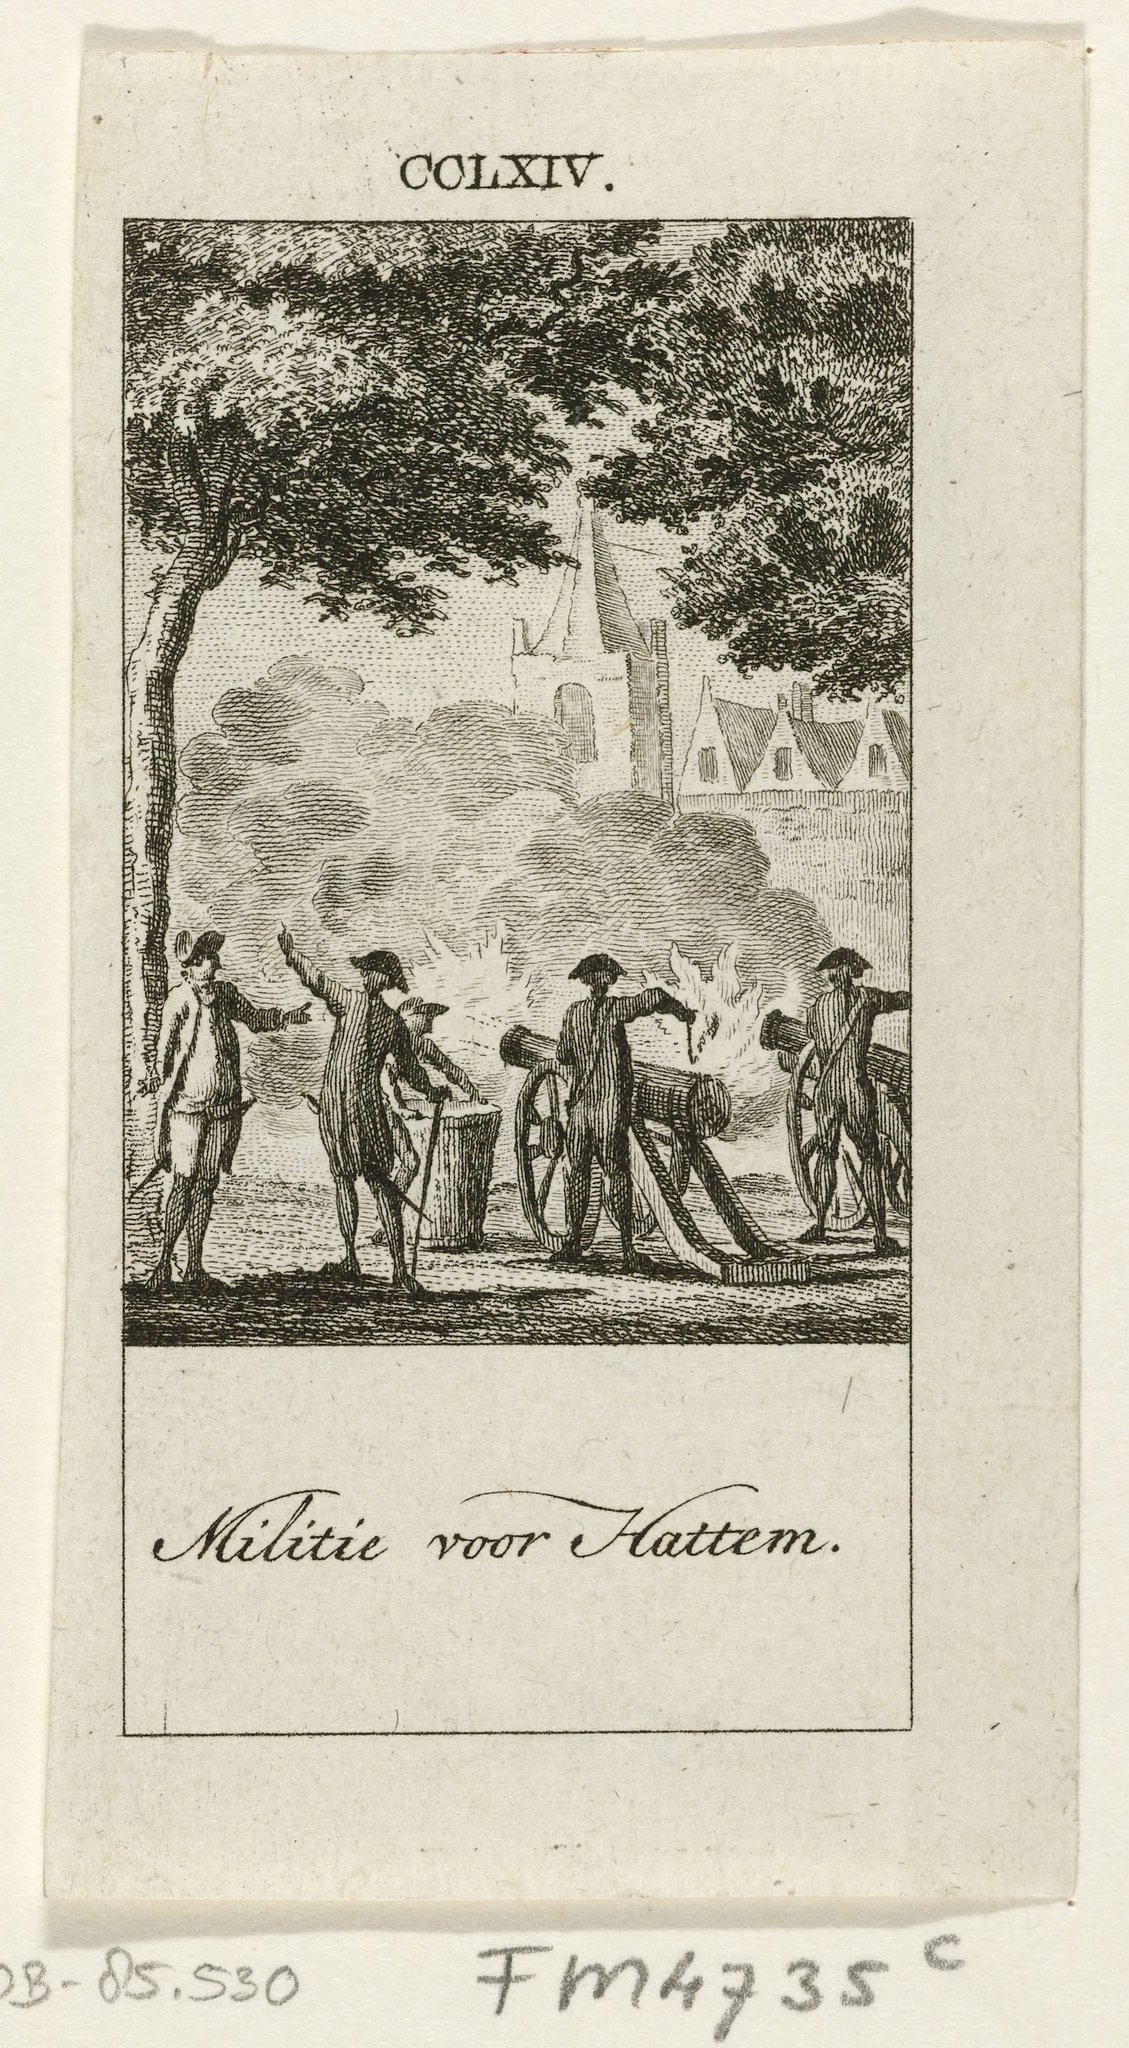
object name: print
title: Beschieting van Hattem, 1786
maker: Anonymous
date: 1786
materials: paper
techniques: engraving, etching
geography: northern netherlands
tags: bombardment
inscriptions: collector's mark: Lugt 2228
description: Beschieting van de stad Hattem door de stadhouderlijke troepen onder generaal-majoor J.C. Spengler op 5 september 1786. Gemerkt bovenaan: CCLXIV.